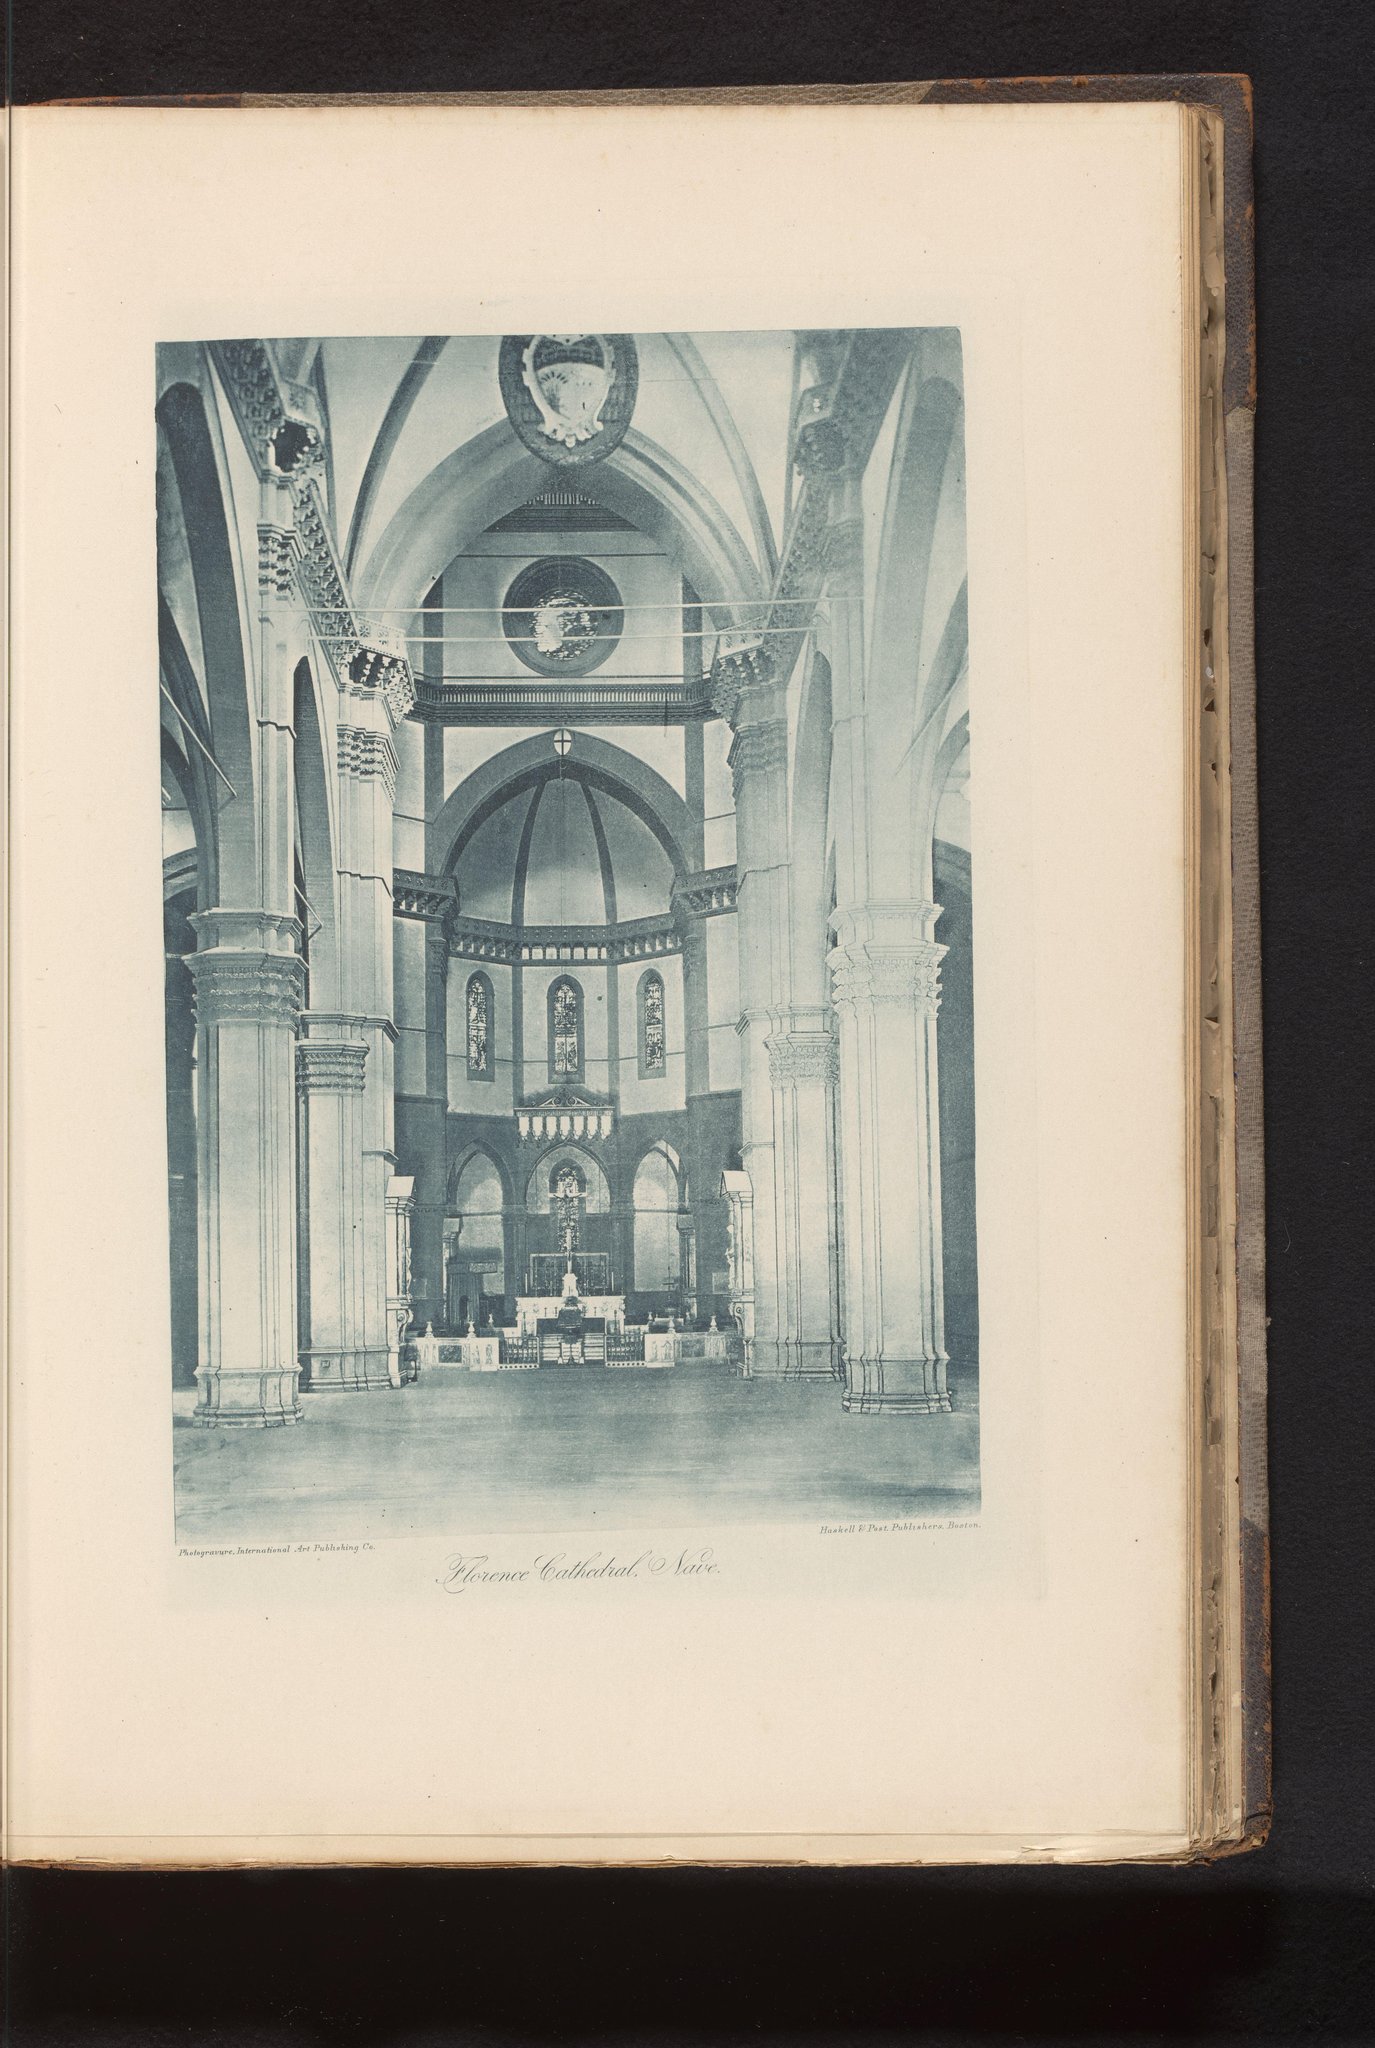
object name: photomechanical print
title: Florence Cathedral, Nave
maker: Anonymous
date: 1881-1886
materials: paper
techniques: photograph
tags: parts of church interior: nave